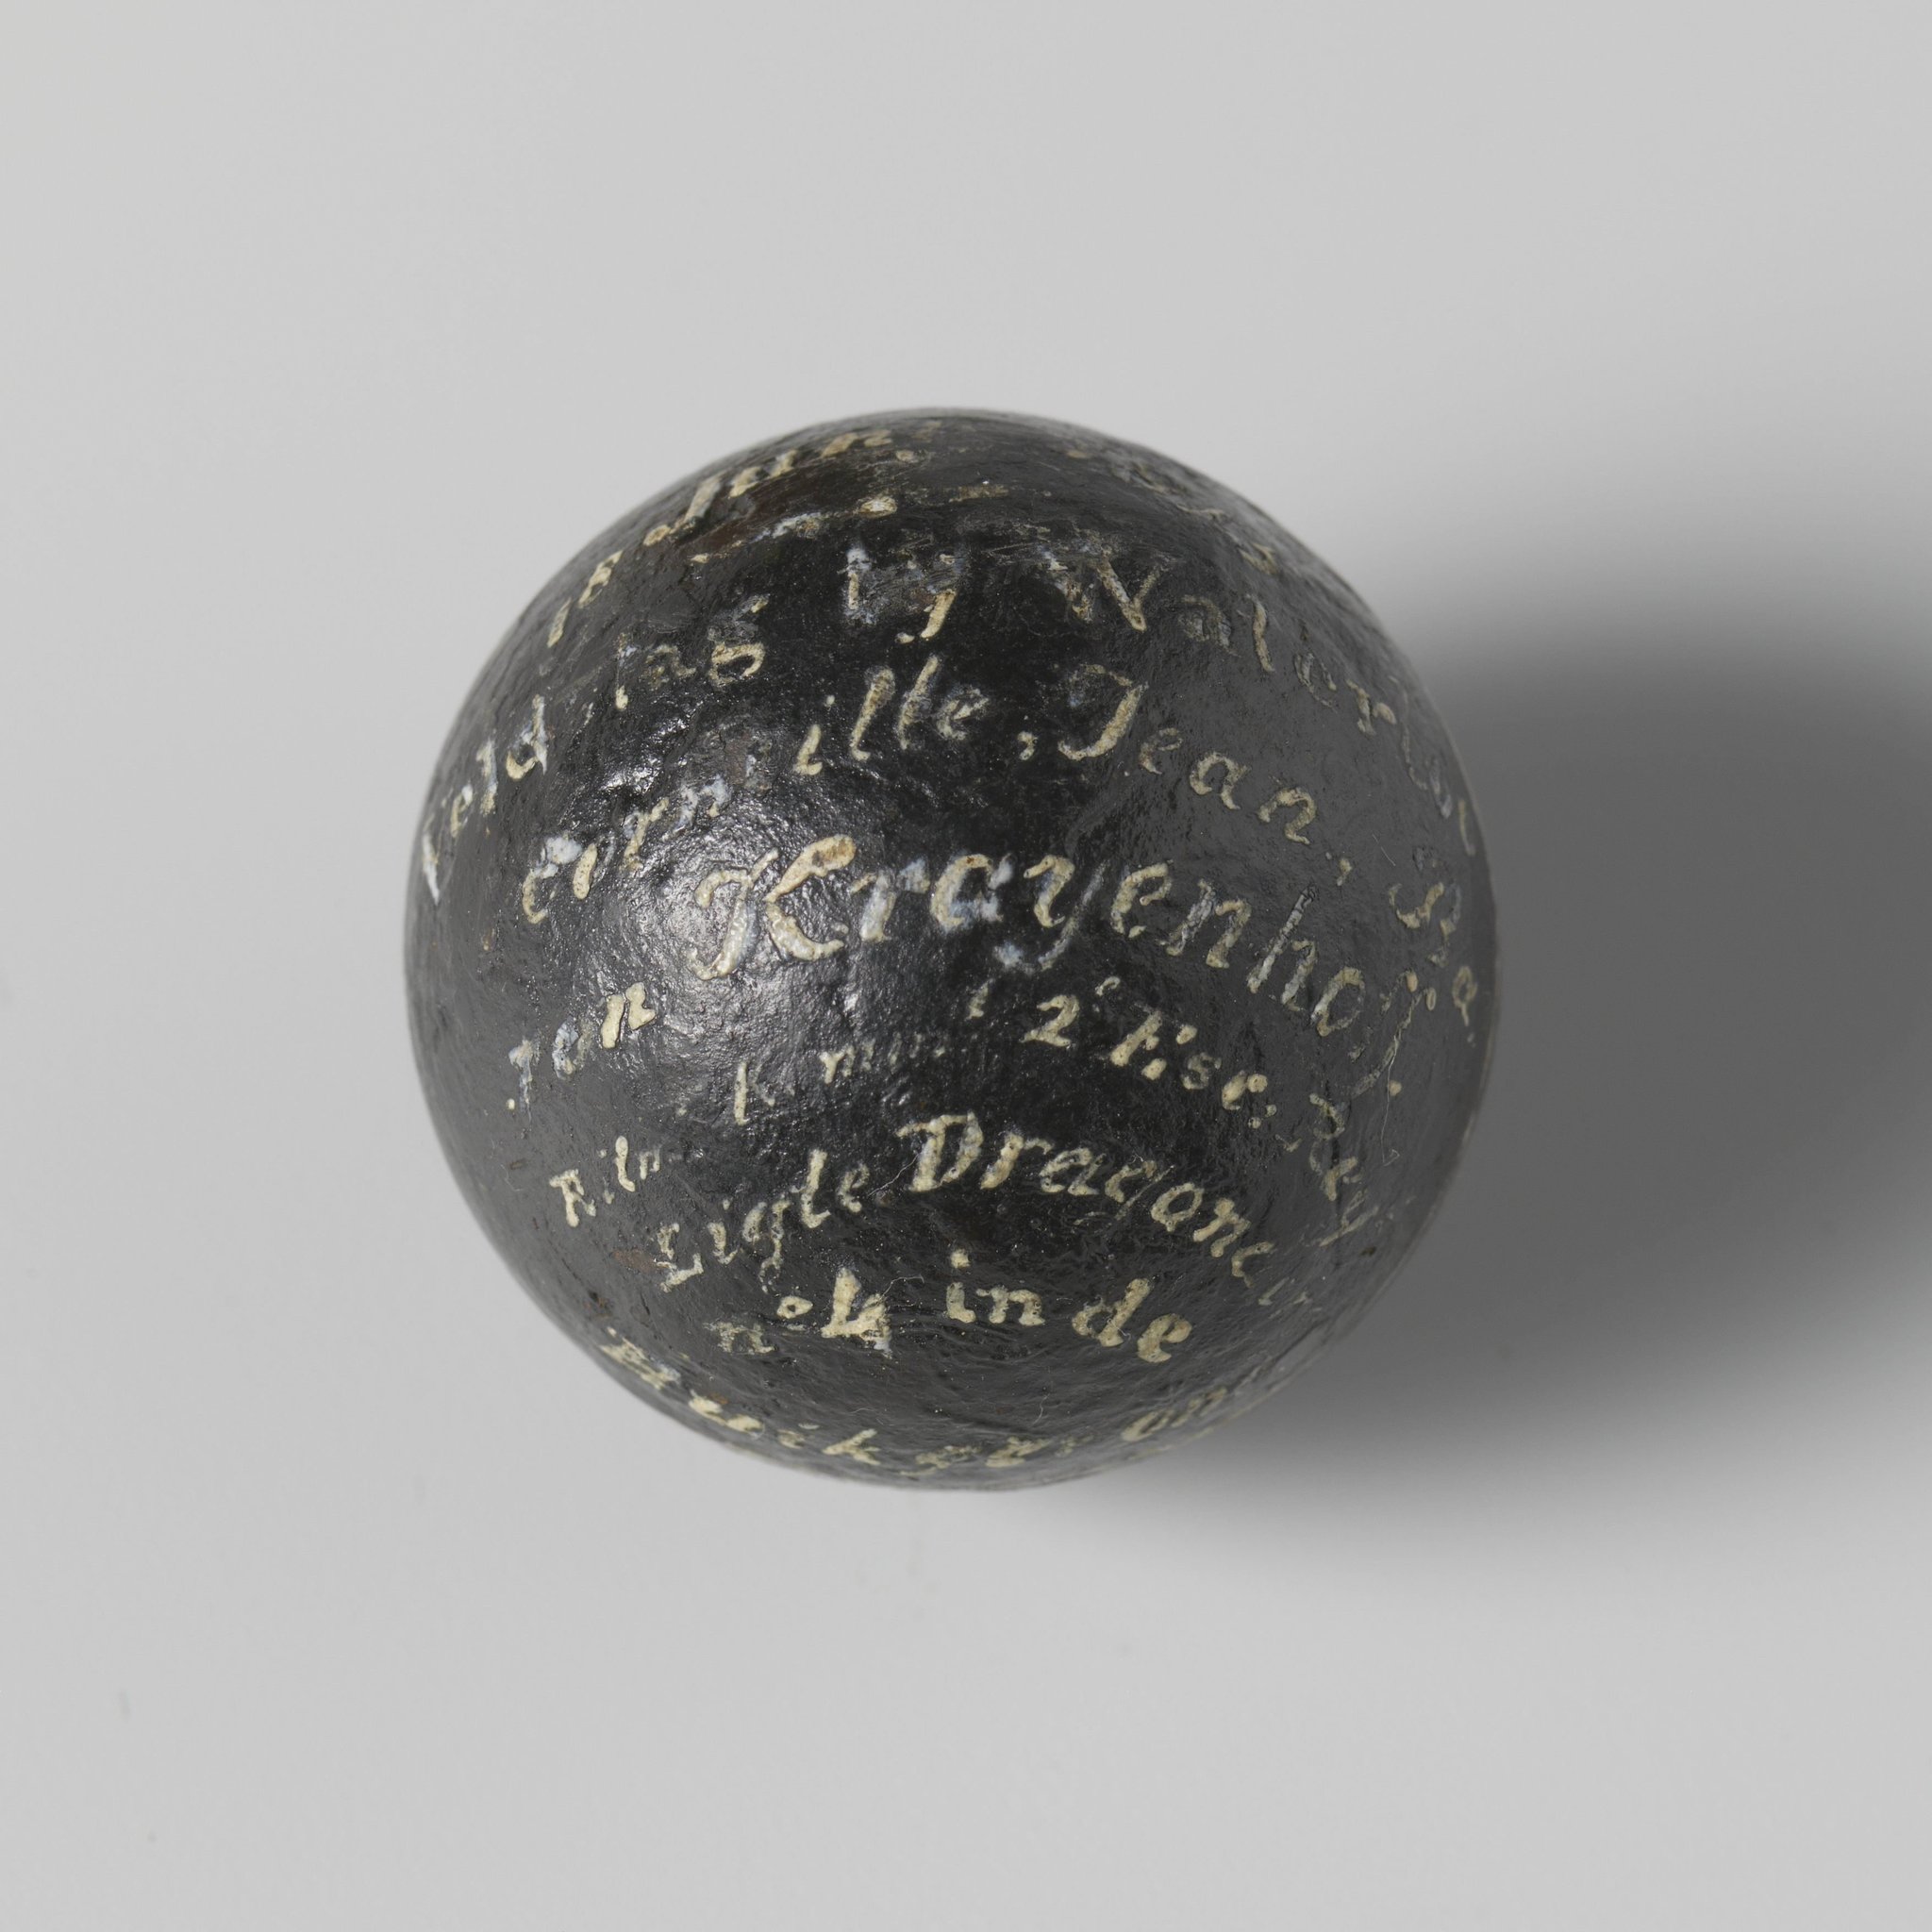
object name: grapeshot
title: Kogel waarmee C.J. baron Krayenhoff in de buik werd getroffen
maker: Anonymous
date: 1815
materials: iron, oil, wood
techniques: casting, turning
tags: c.j. baron krayenhoff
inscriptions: inscription: ‘Veldslag bij Waterloo / Corneille. Jean. Ba / ron Krayenhoff. Ritm. Komm.t / 2e F.sc: Regt / Ligte Dragonders / no 4 in de / Buik gewond’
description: Ronde kogel waarvan één helft zwart geverfd is met daarop in witte verf het opschrift. In ronde doos van hout die bestaat uit twee helften die op elkaar zijn te schroeven.